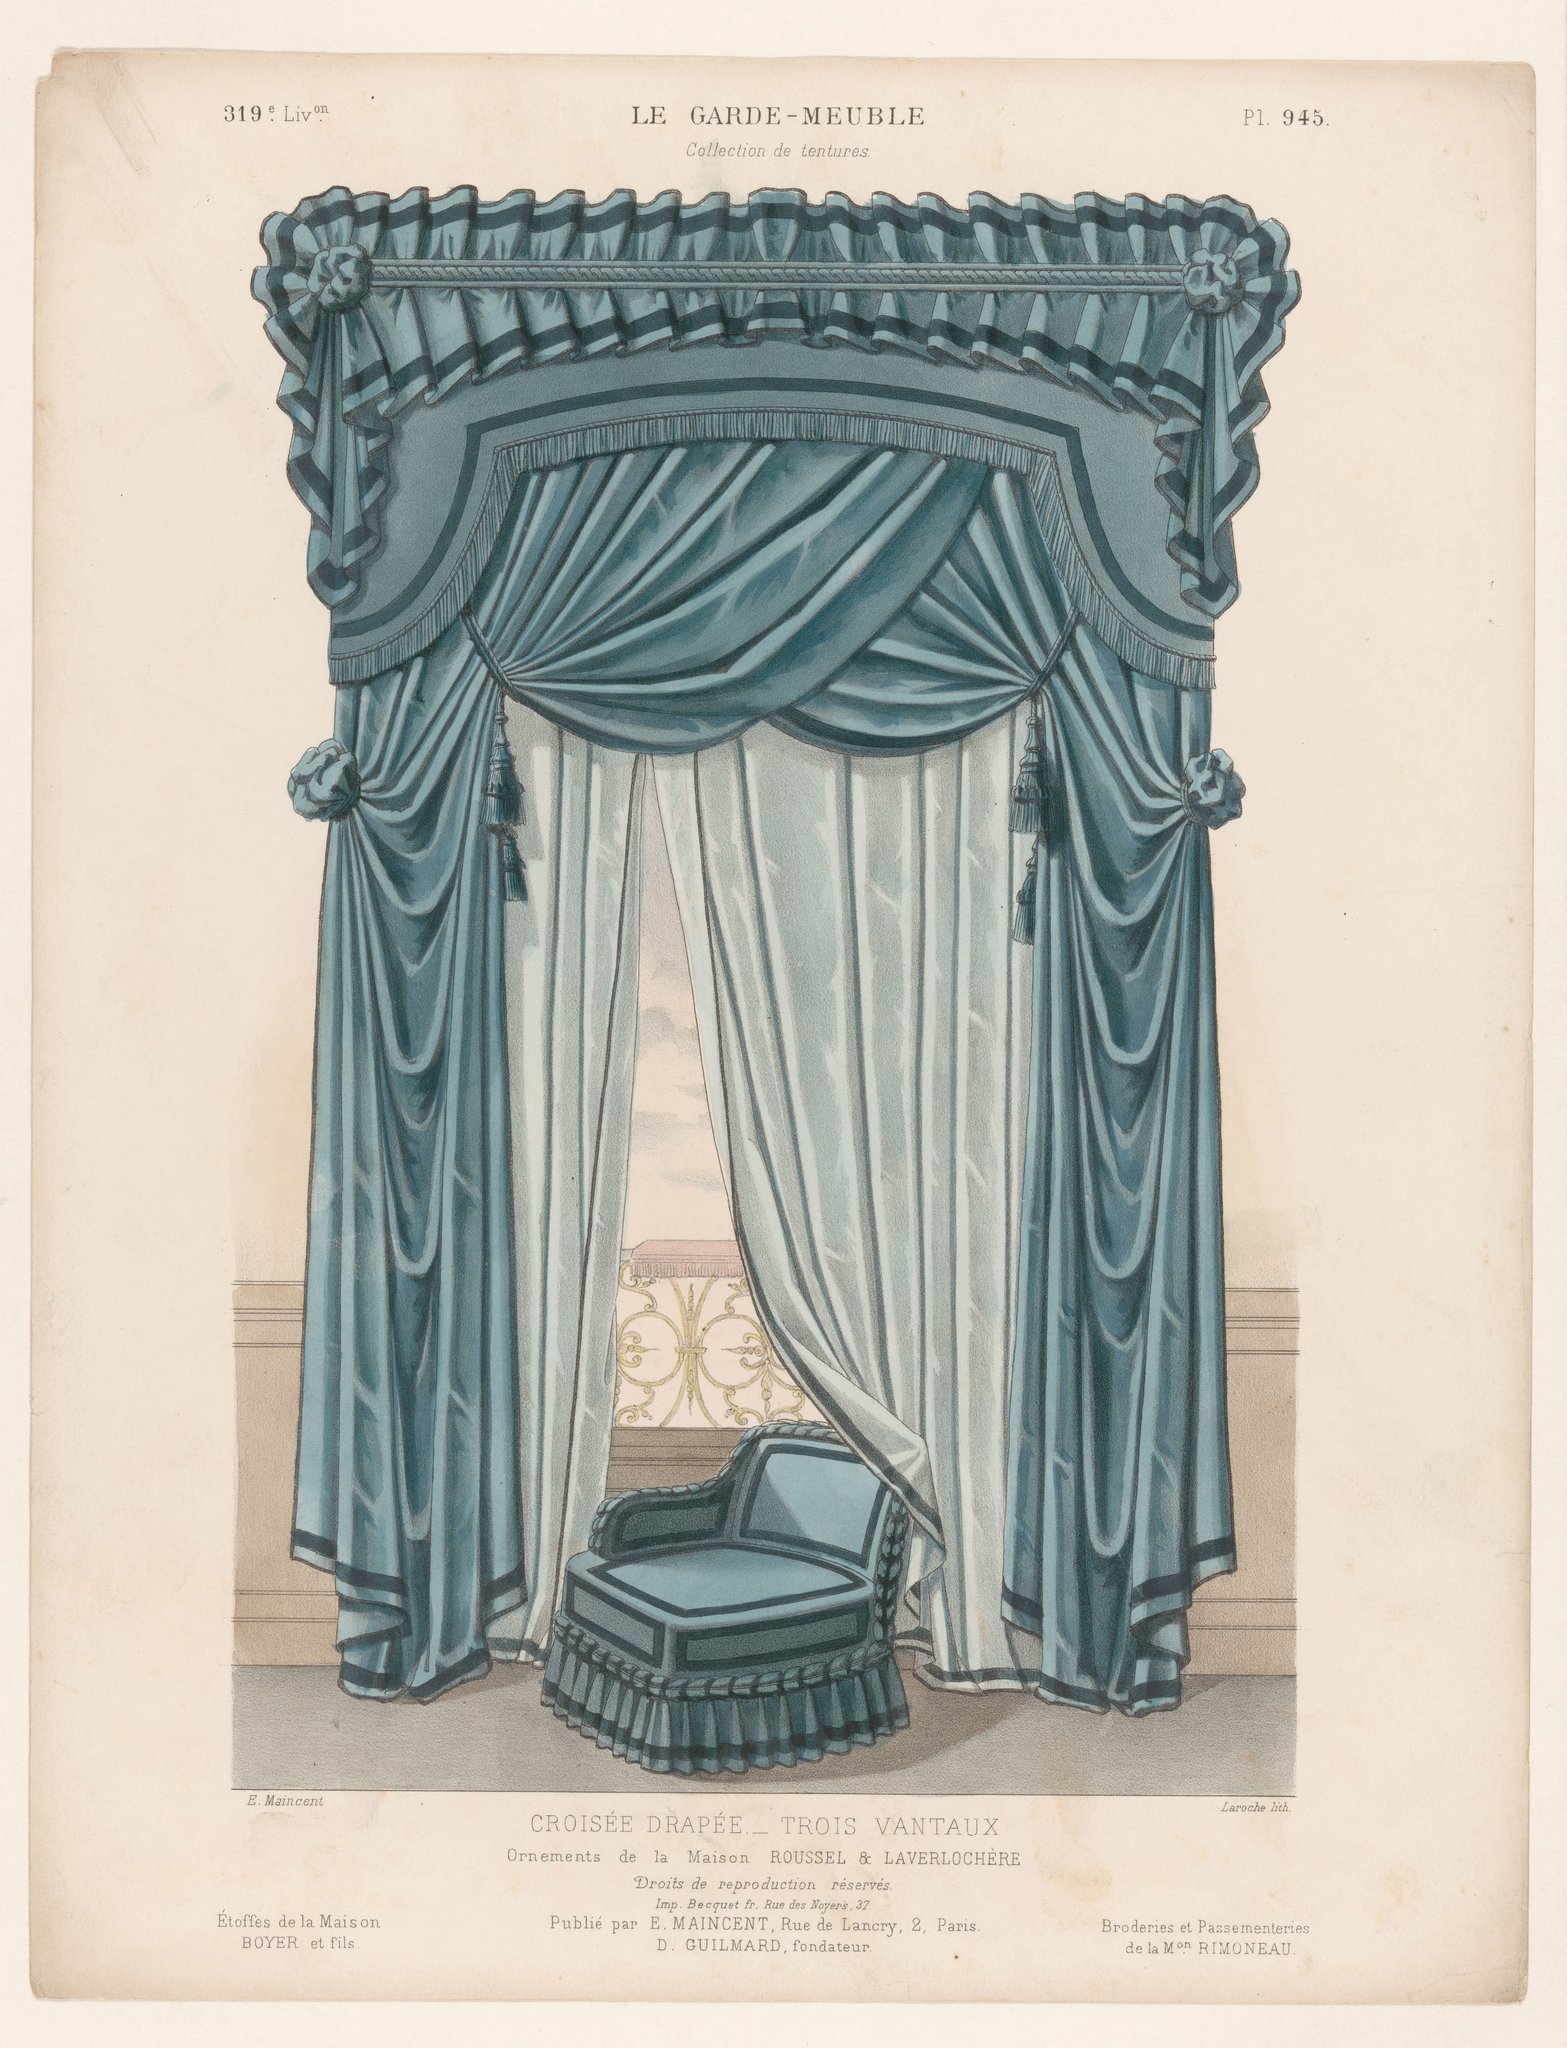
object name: print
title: Croisée drapée - Trois Vantaux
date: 1885-1895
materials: paper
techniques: hand coloring, lithograph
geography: paris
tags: armchair, seat, window, hangings and drapery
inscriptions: : ‘Droits de reproduction réservés.’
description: Kruisvenster met fauteuil en gedrapeerde gordijnen (driedelig). Prent uit 319e Livraison.